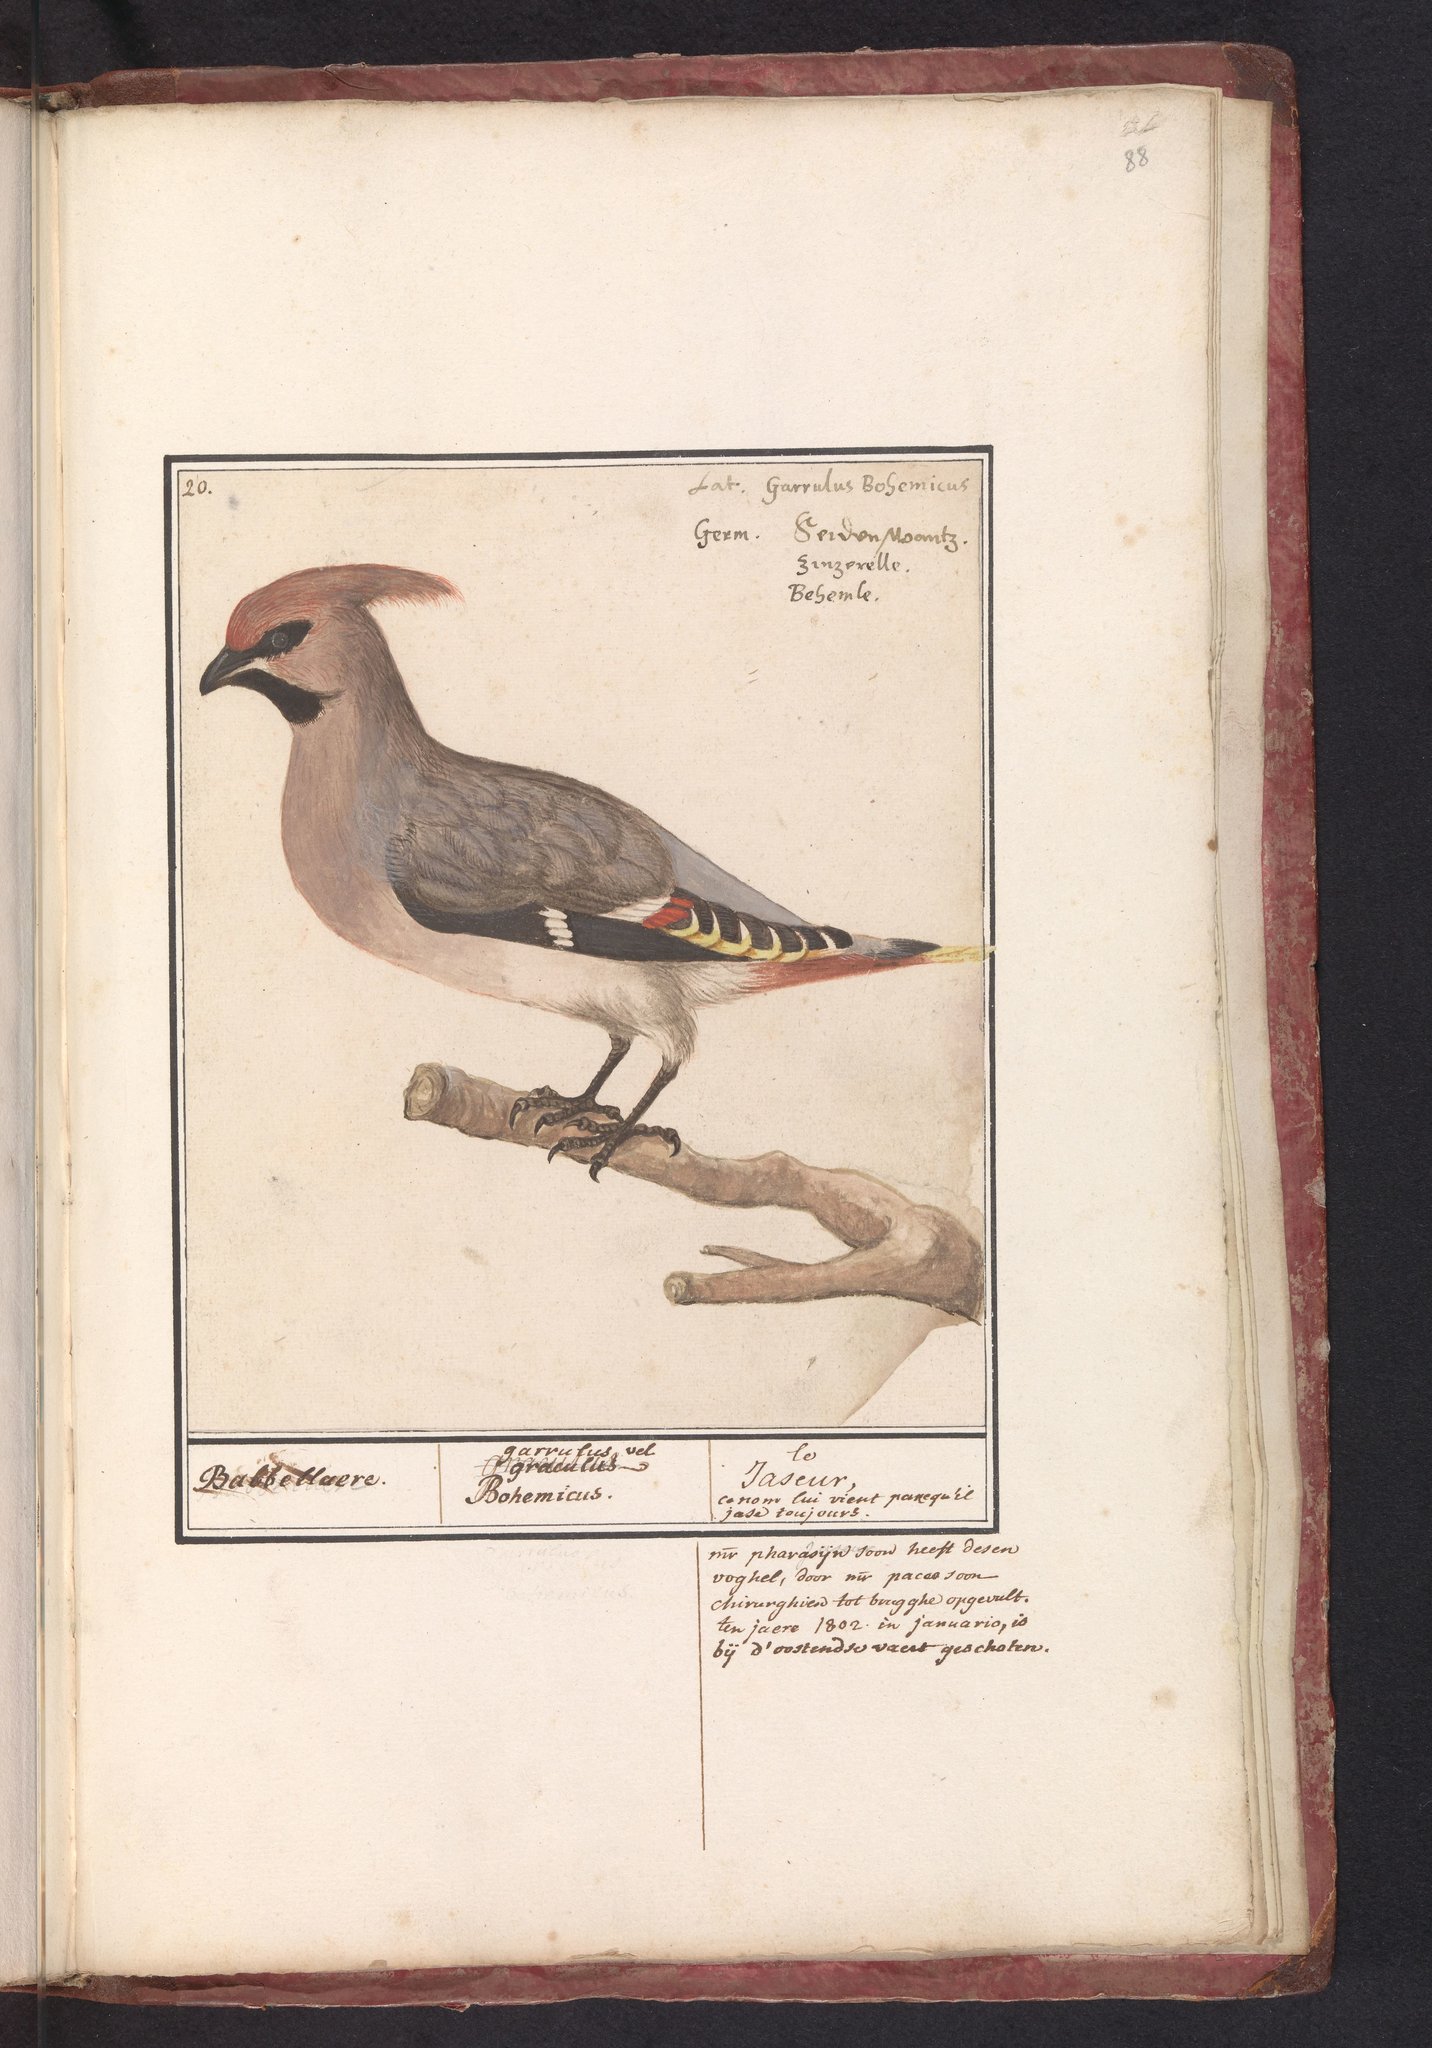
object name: drawing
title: Pestvogel (Bombycilla garrulus)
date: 1596-1610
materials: paint, ink, paper, watercolor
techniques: brush, pen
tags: song-birds: bohemian waxwing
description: Pestvogel. Genummerd linksboven: 20. Rechtsboven de naam in vier talen. Onderaan op het blad een annotatie over een in 1802 te Oostende geschoten exemplaar. Onderdeel van het eerste album met tekeningen van vogels. Derde van twaalf albums met tekeningen van dieren, vogels en planten bekend rond 1600, gemaakt in opdracht van keizer Rudolf II. Met toelichting in Nederlands, Latijn en Frans.